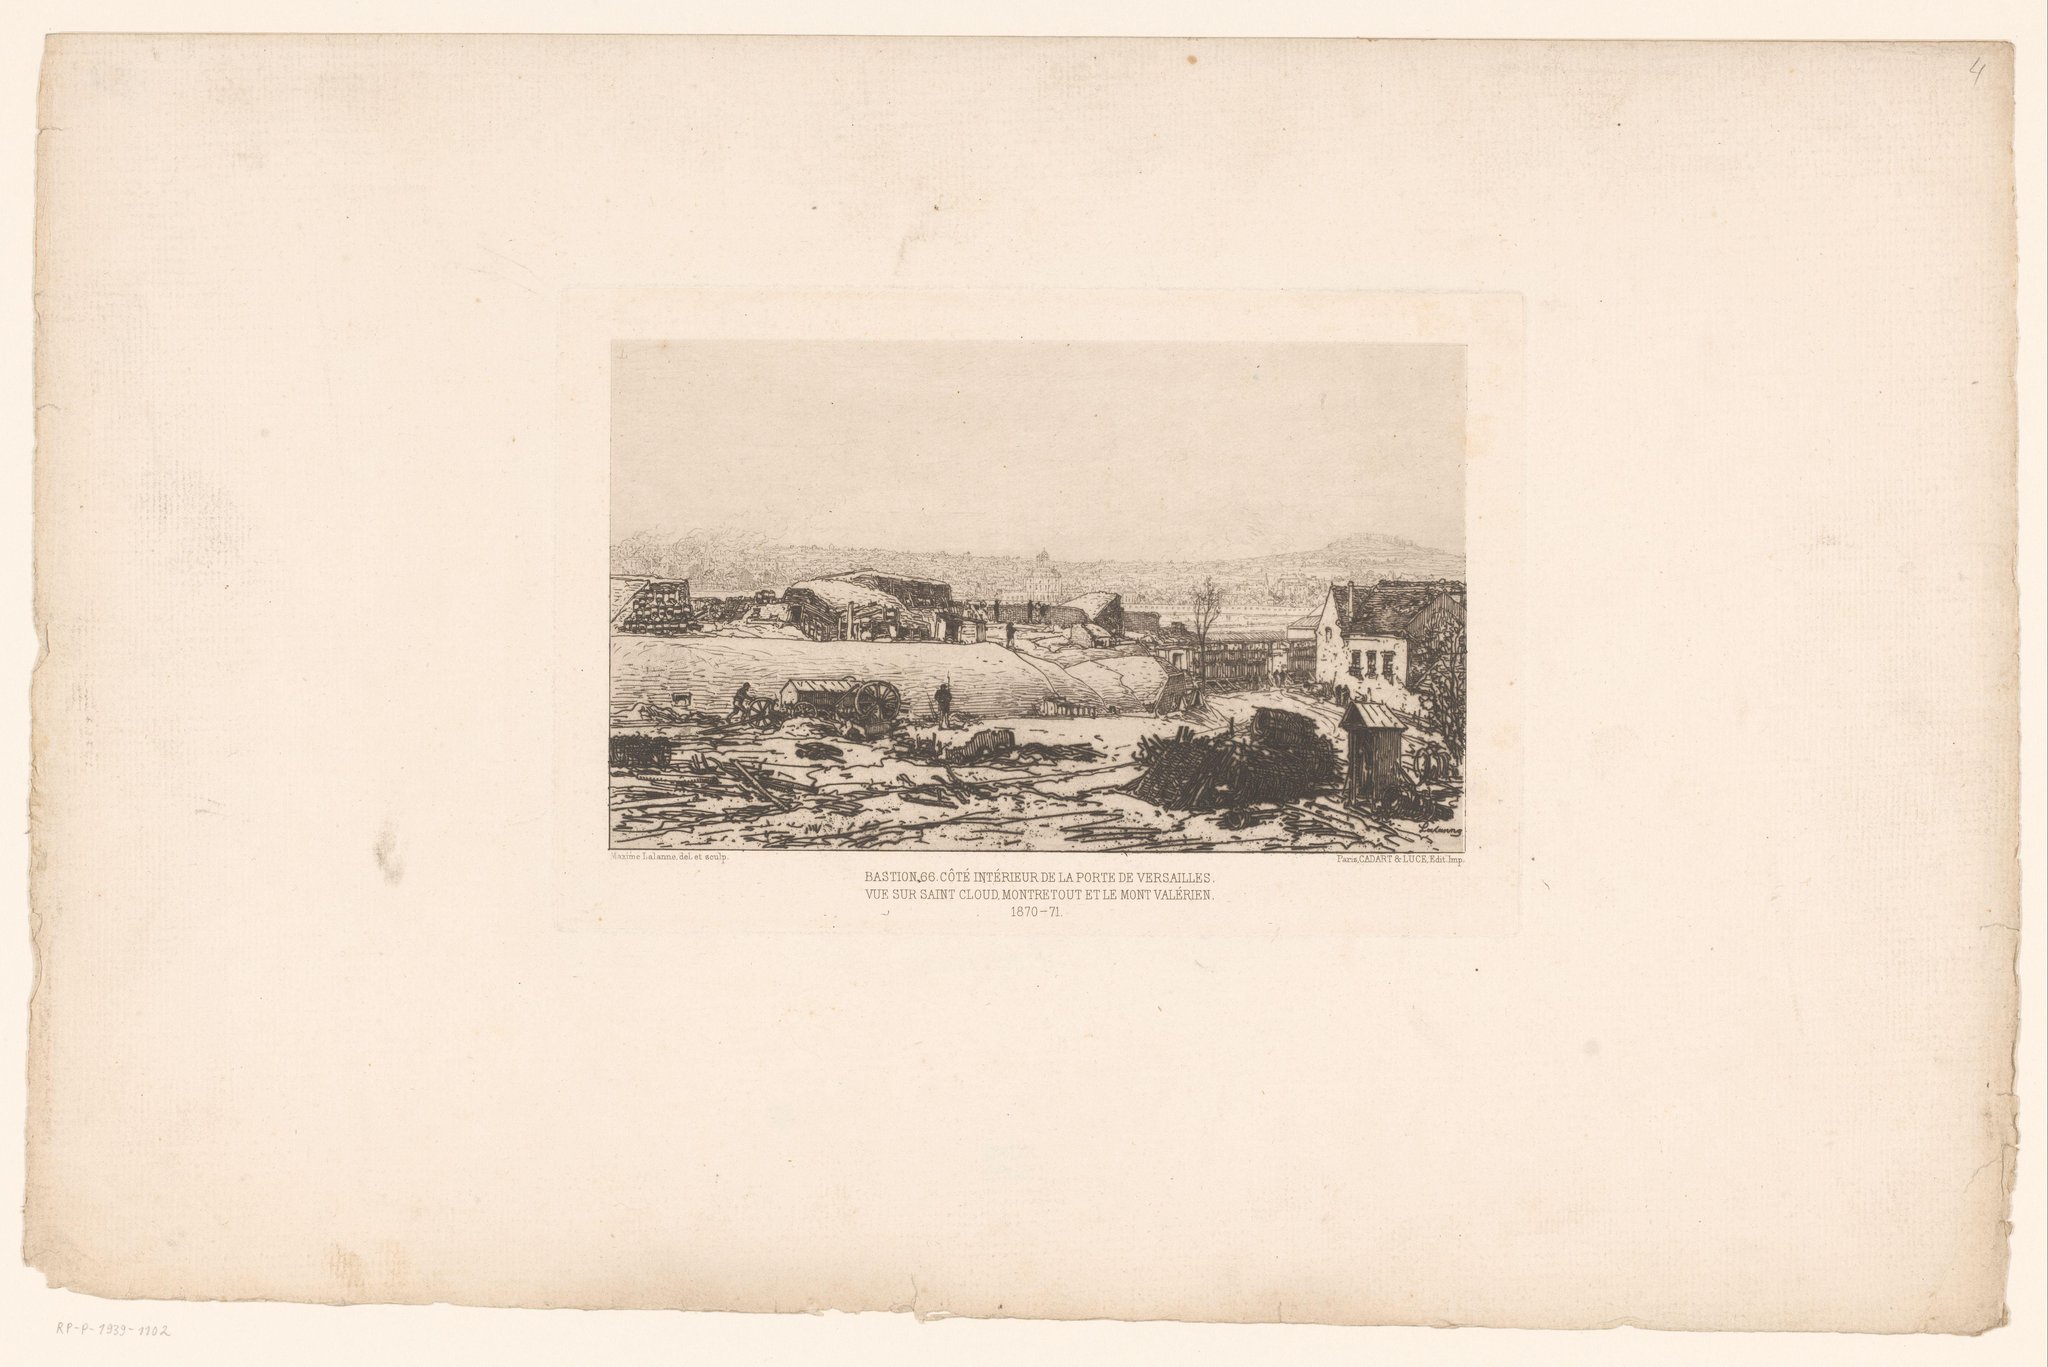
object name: print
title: Acht prenten met taferelen uit het Beleg van Parijs (1870-1871)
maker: maxime françois antoine lalanne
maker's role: draughtsman, print maker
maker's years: 1827-1886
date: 1871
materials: paper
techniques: drypoint, engraving, etching, intaglio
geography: paris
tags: bastion, bulwark, siege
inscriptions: collector's mark: Lugt 2166, collector's mark: Lugt 2760, watermark